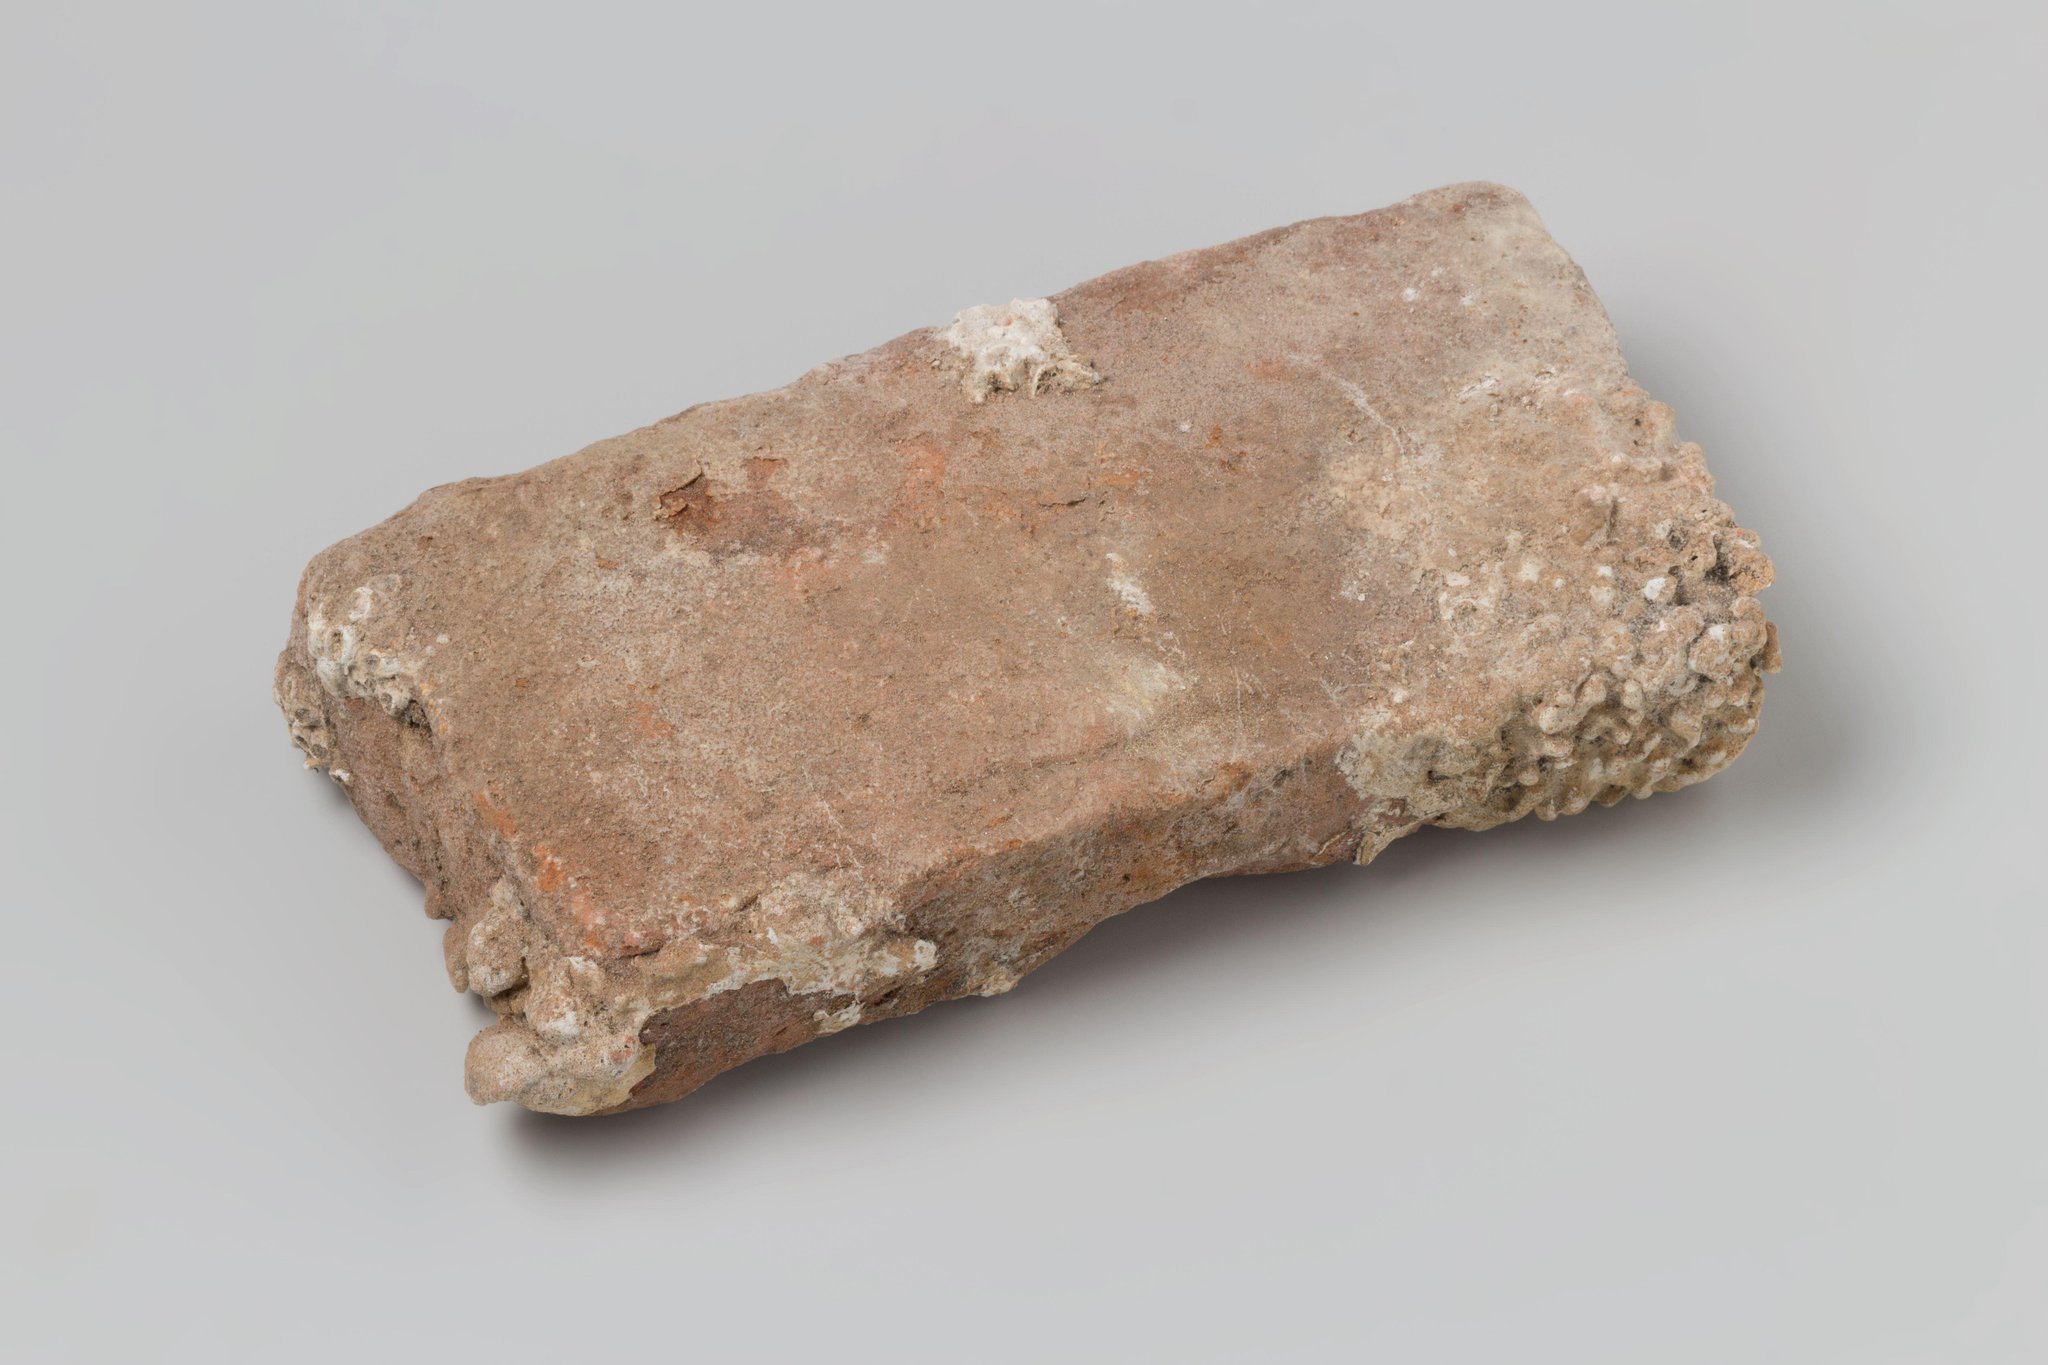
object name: brick clay product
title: Roodbruine baksteen uit V.O.C.-schip de 'Witte Leeuw'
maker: Anonymous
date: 1613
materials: brick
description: Baksteen. Met witte koraalachtige aanslag.